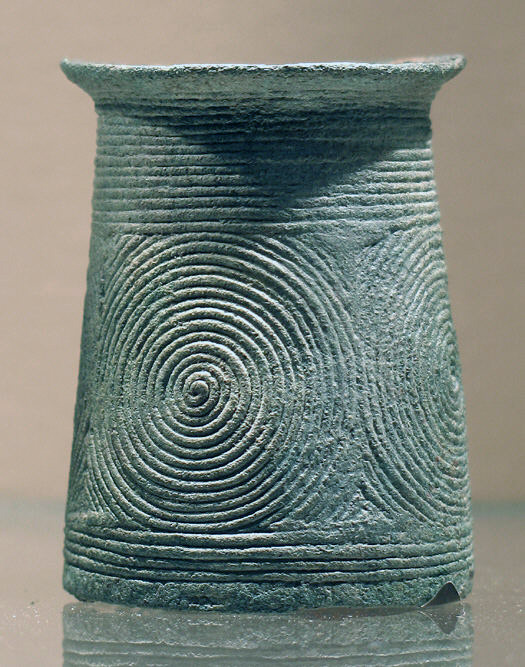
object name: cuff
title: Small Cuff with Concentric Circles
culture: thai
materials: bronze